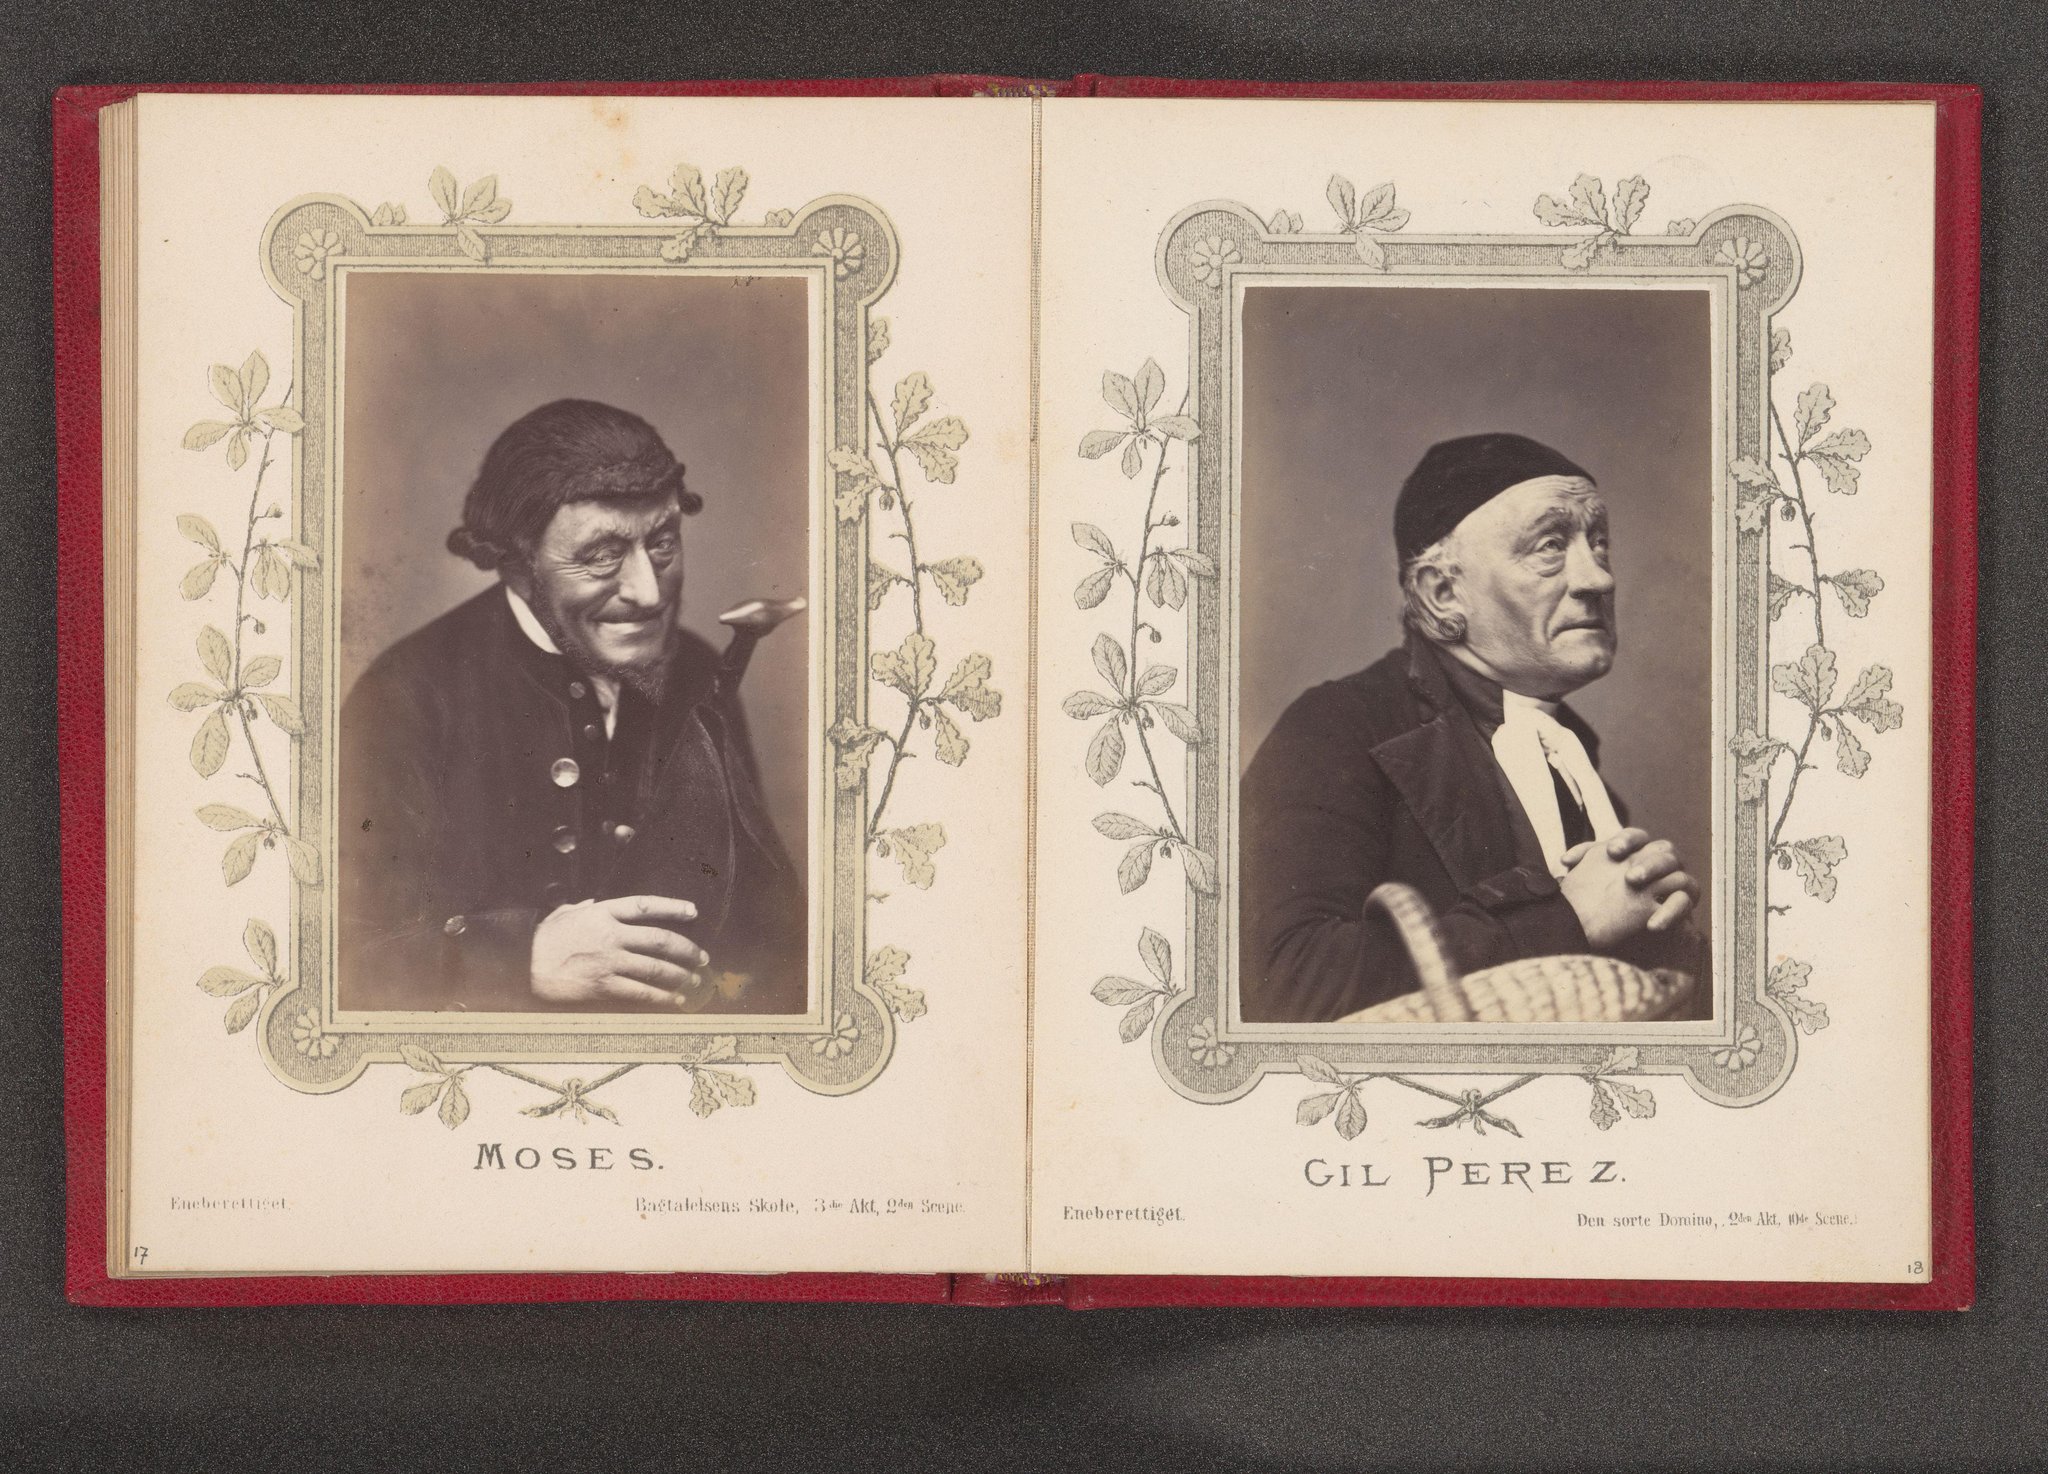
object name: photograph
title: Gil Perez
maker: harald paetz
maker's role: fotograaf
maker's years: 1837-1895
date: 1862-1872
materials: photographic support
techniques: albumen print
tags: stage costume, portrait of actor, actress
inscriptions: inscription: ‘Eneberettiget Den sorte Domino, 2den Akt, 10de Scene.’